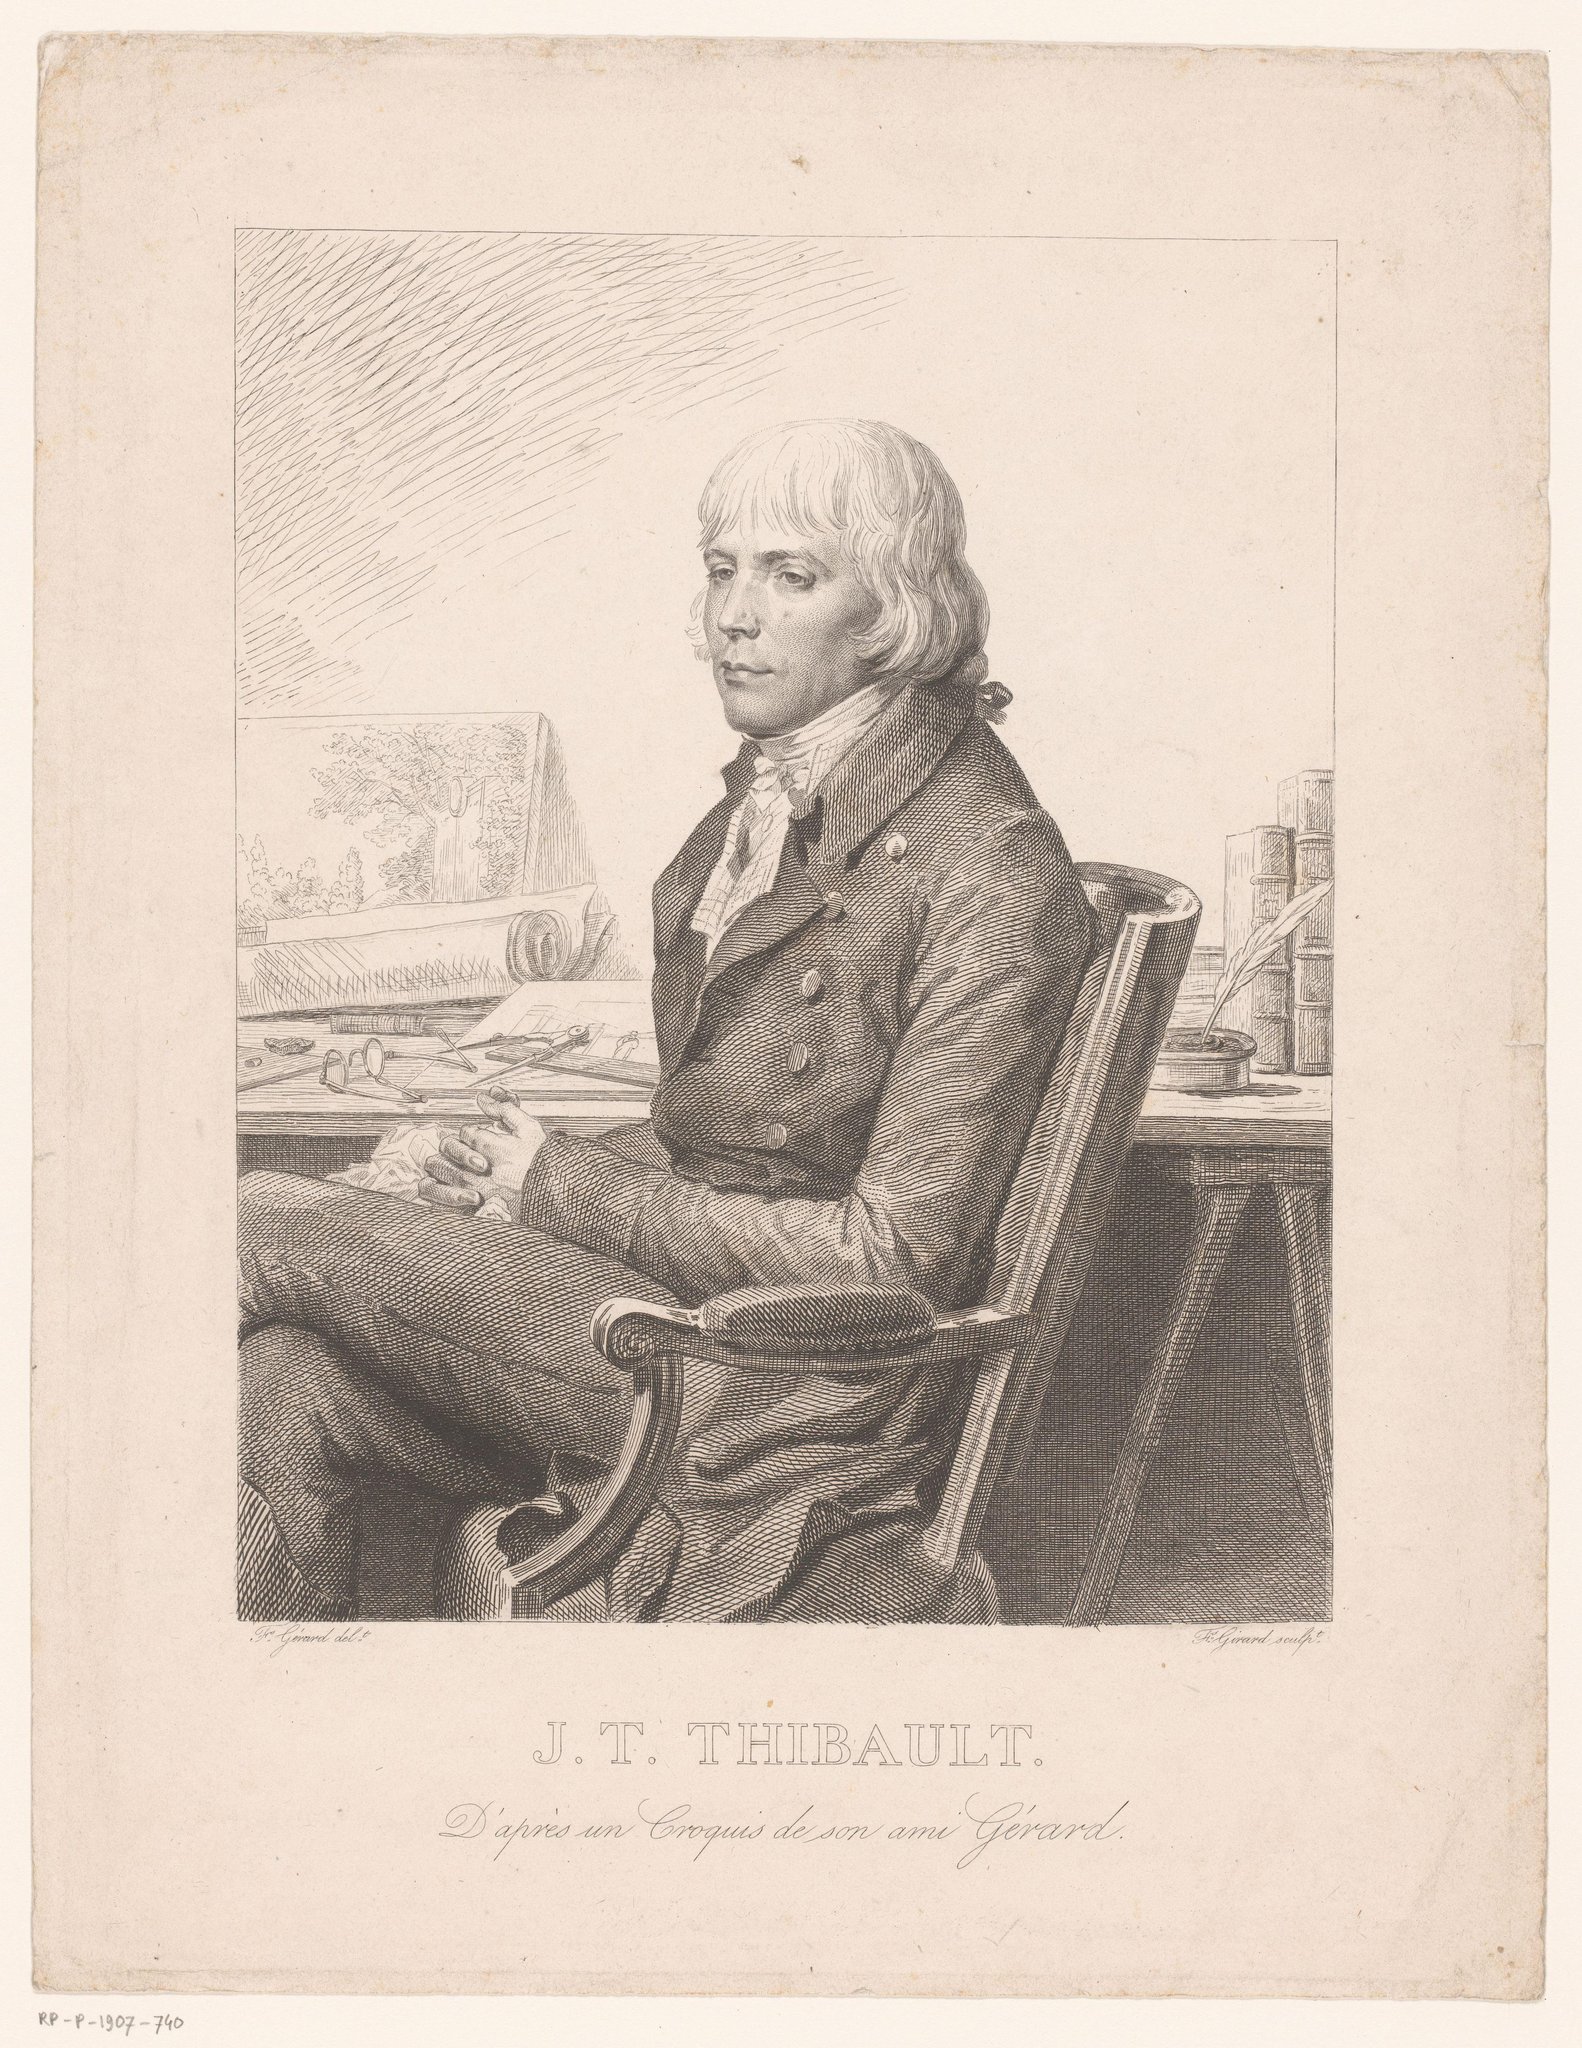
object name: print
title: Portret van Jean-Thomas Thibault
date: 1823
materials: paper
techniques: engraving, etching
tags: paris, historical persons, portrait, self-portrait of artist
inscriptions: collector's mark: Lugt 2228